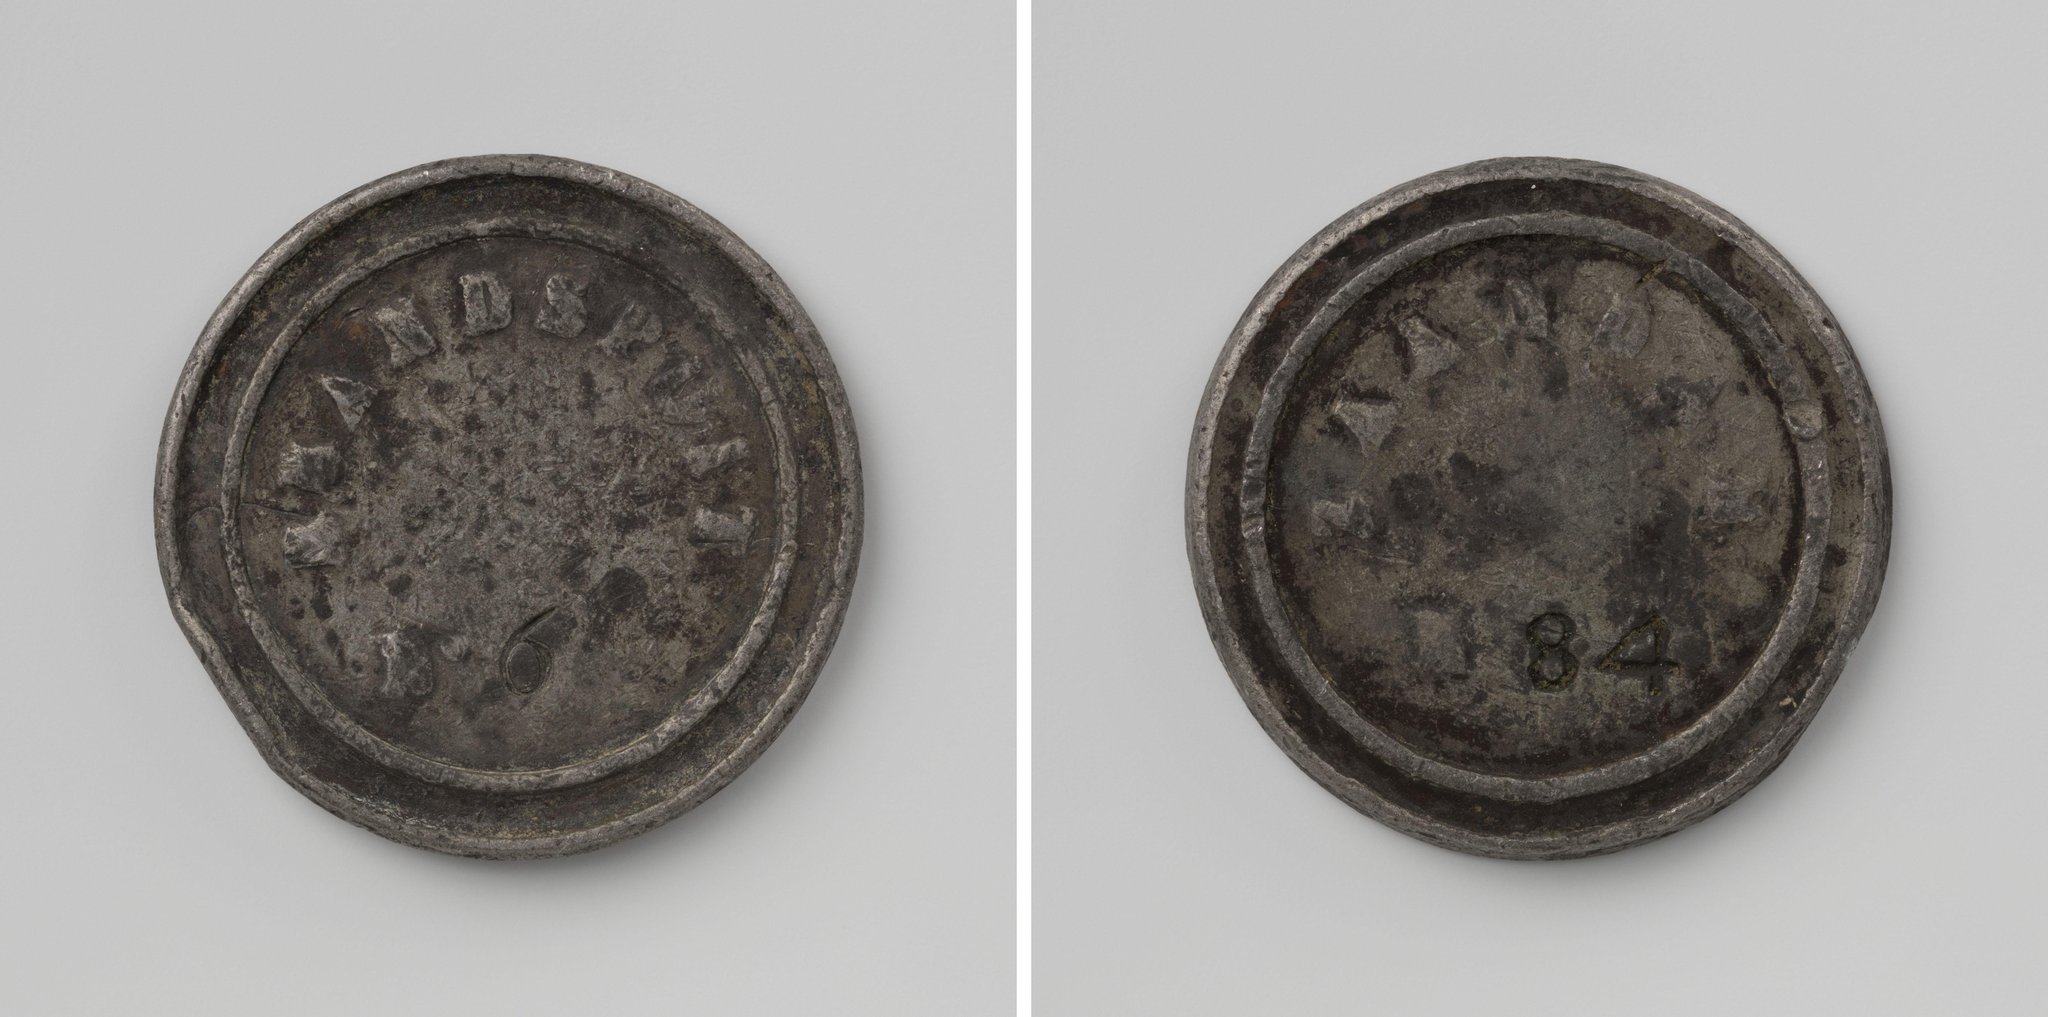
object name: fire engine medal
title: Zaandam, brandspuitpenning van spuit 6 met no. 84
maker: Anonymous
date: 1680-1800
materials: lead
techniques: casting, engraving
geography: zaandam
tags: zaandam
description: Loden penning. Voorzijde: cijfer 6 binnen omschrift. Keerzijde: cijfer 84 binnen omschrift